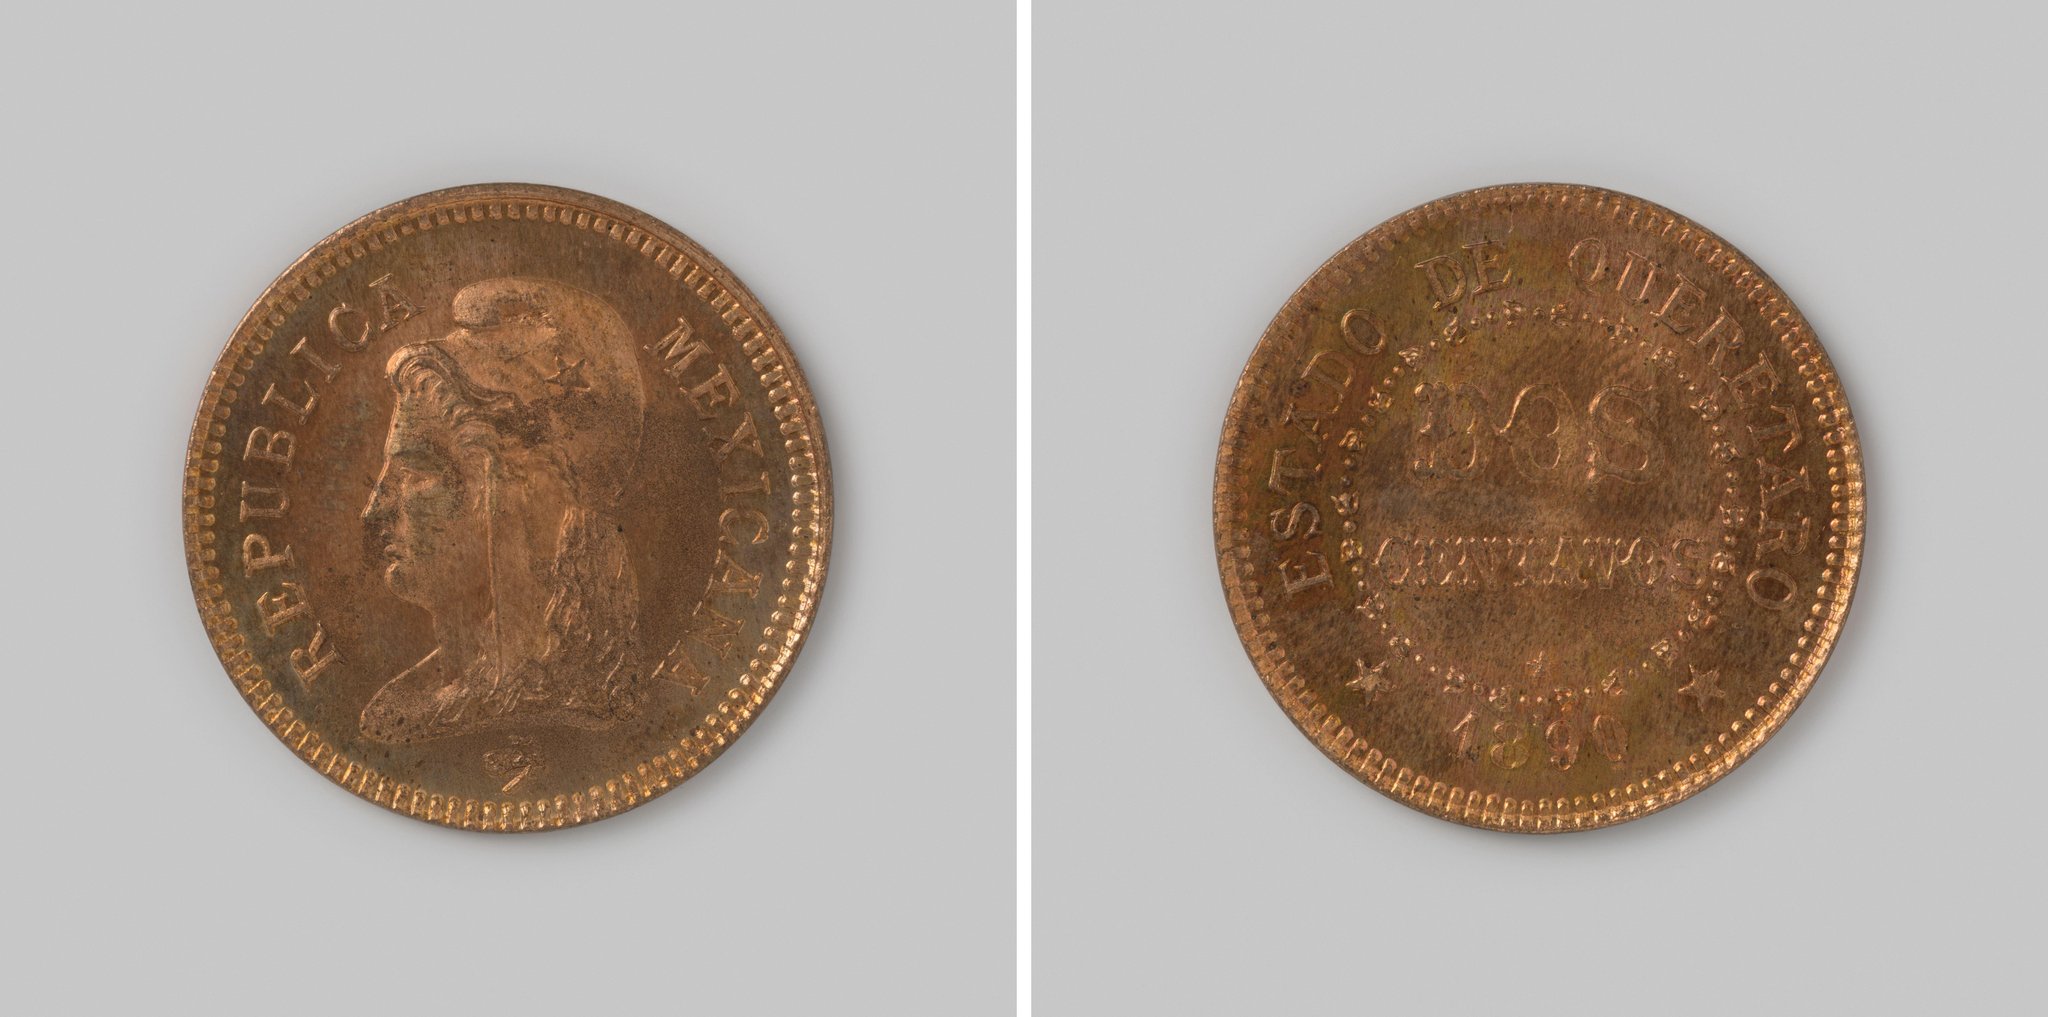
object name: coin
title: Staat Queretara, Mexico, 2 centavos, 1890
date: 1890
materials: copper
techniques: striking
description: Koperen munt. Voorzijde: portret van vrouw naar links met op haar hoofd Frygische vrijheidshoed. Keerzijde: binnen versiering in cirkelvorm waarde-aanduiding in twee regels. Jaartal in omschrift onderaan. Gladde rand.